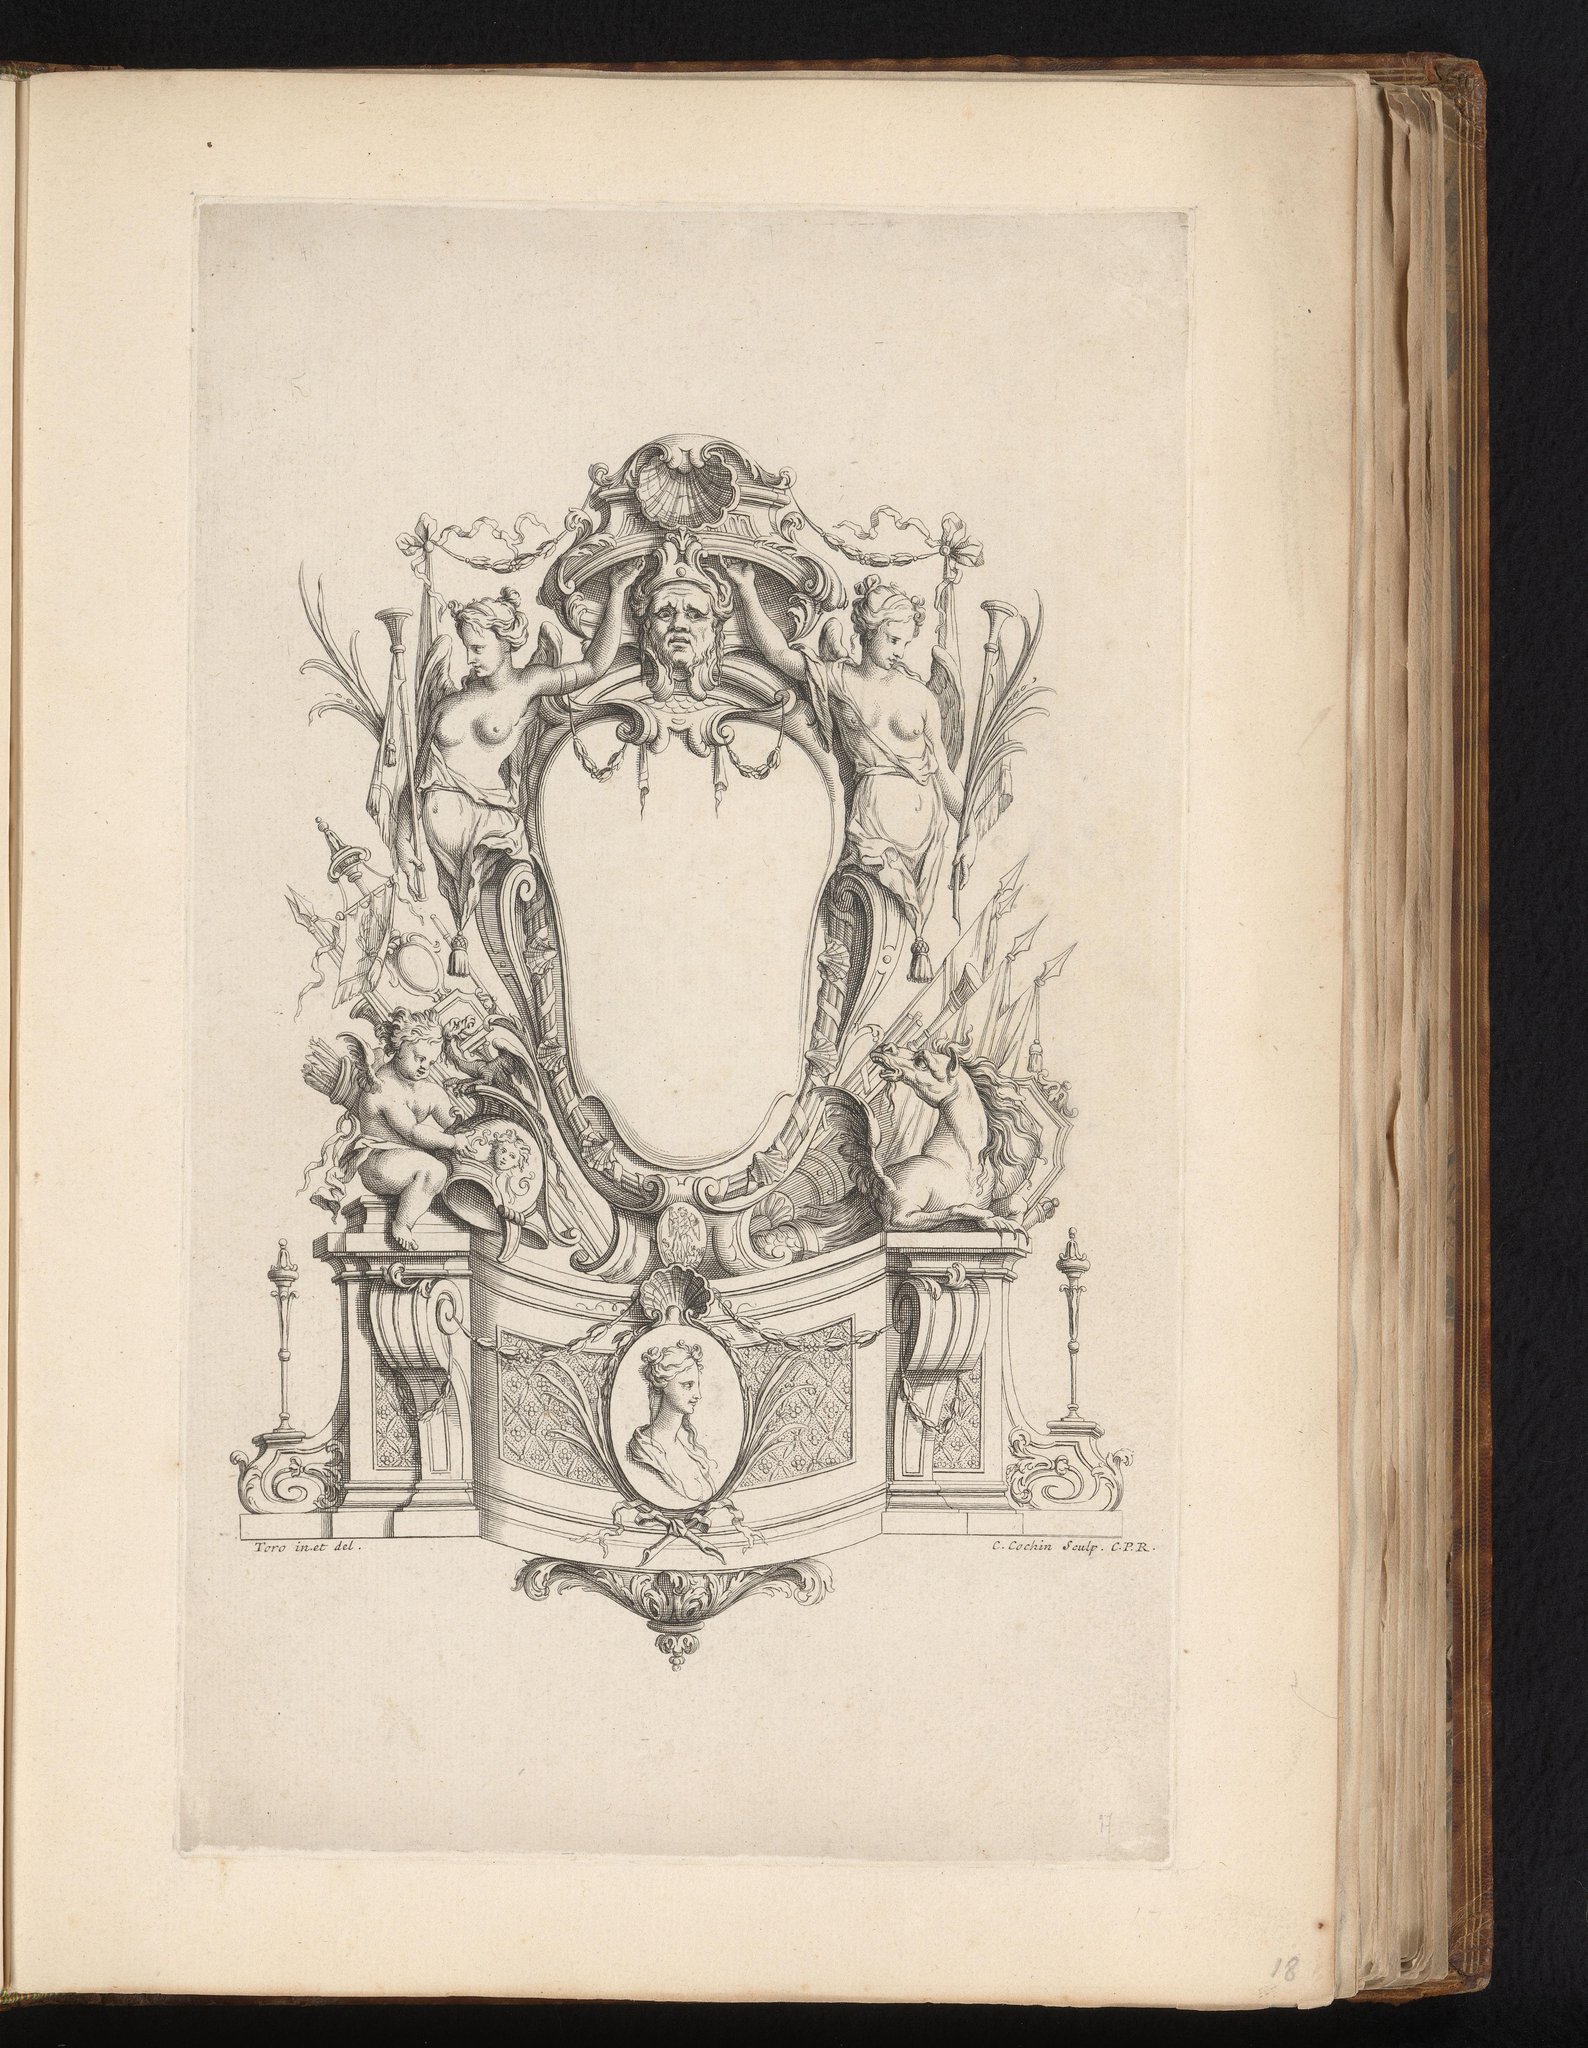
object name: ornament print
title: Ontwerpen voor cartouches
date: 1698-1731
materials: paper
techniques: engraving, etching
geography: paris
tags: 'tropaion', i.e. decorative ornament ~ weapons, pedestal of a piece of sculpture (perhaps in the form of a herm), ornament ~ cartouche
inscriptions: collector's mark: Lugt 2228, collector's mark: Lugt 2760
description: Prent maakt deel uit van een serie van zes prenten.